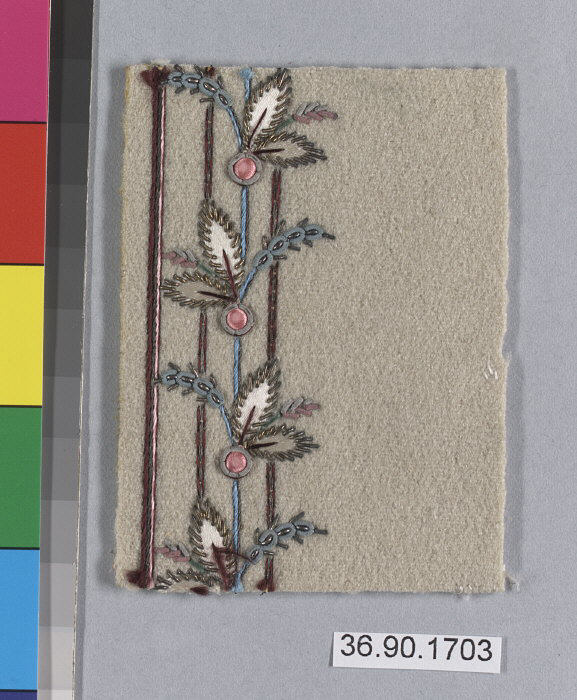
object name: sample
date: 1801-1833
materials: felt, metal thread, silk